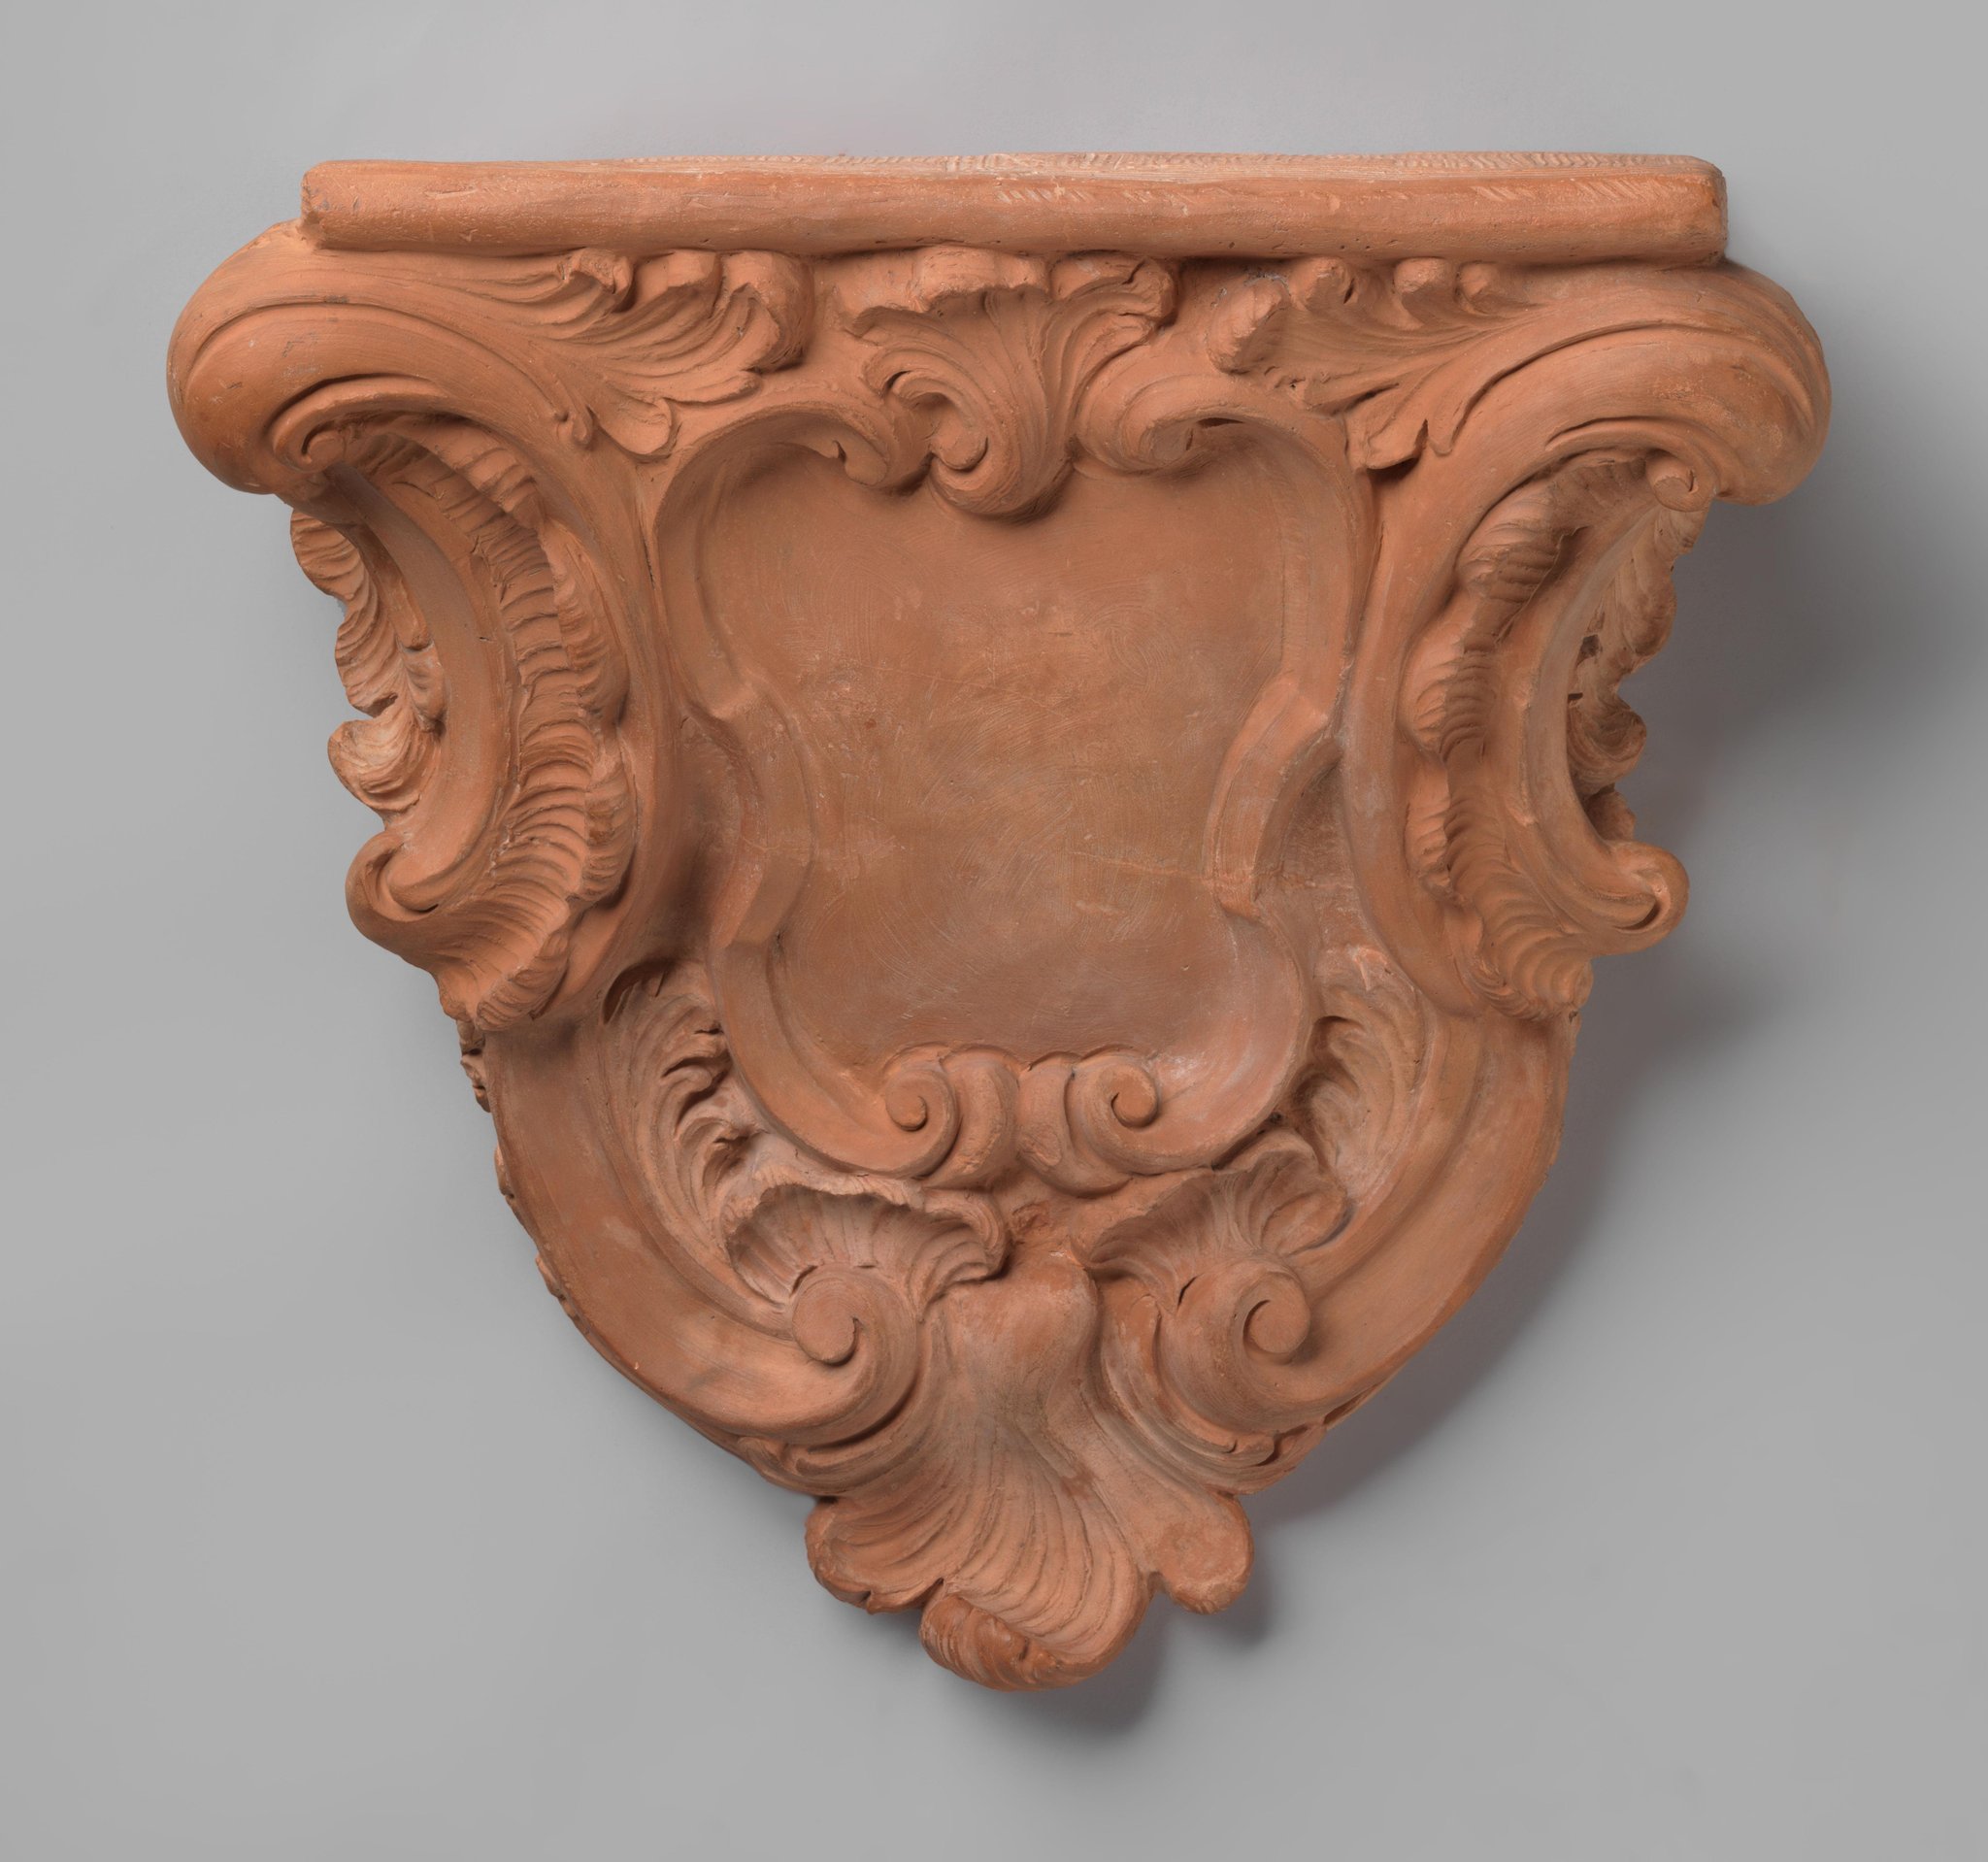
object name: console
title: St James the Less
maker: walter pompe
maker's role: draughtsman, sculptor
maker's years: 1703-1777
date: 1773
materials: terracotta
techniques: modeling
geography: antwerp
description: Walter Pompe (1703 - 1777) St James Minor. Terracotta. Antwerp, 1773.